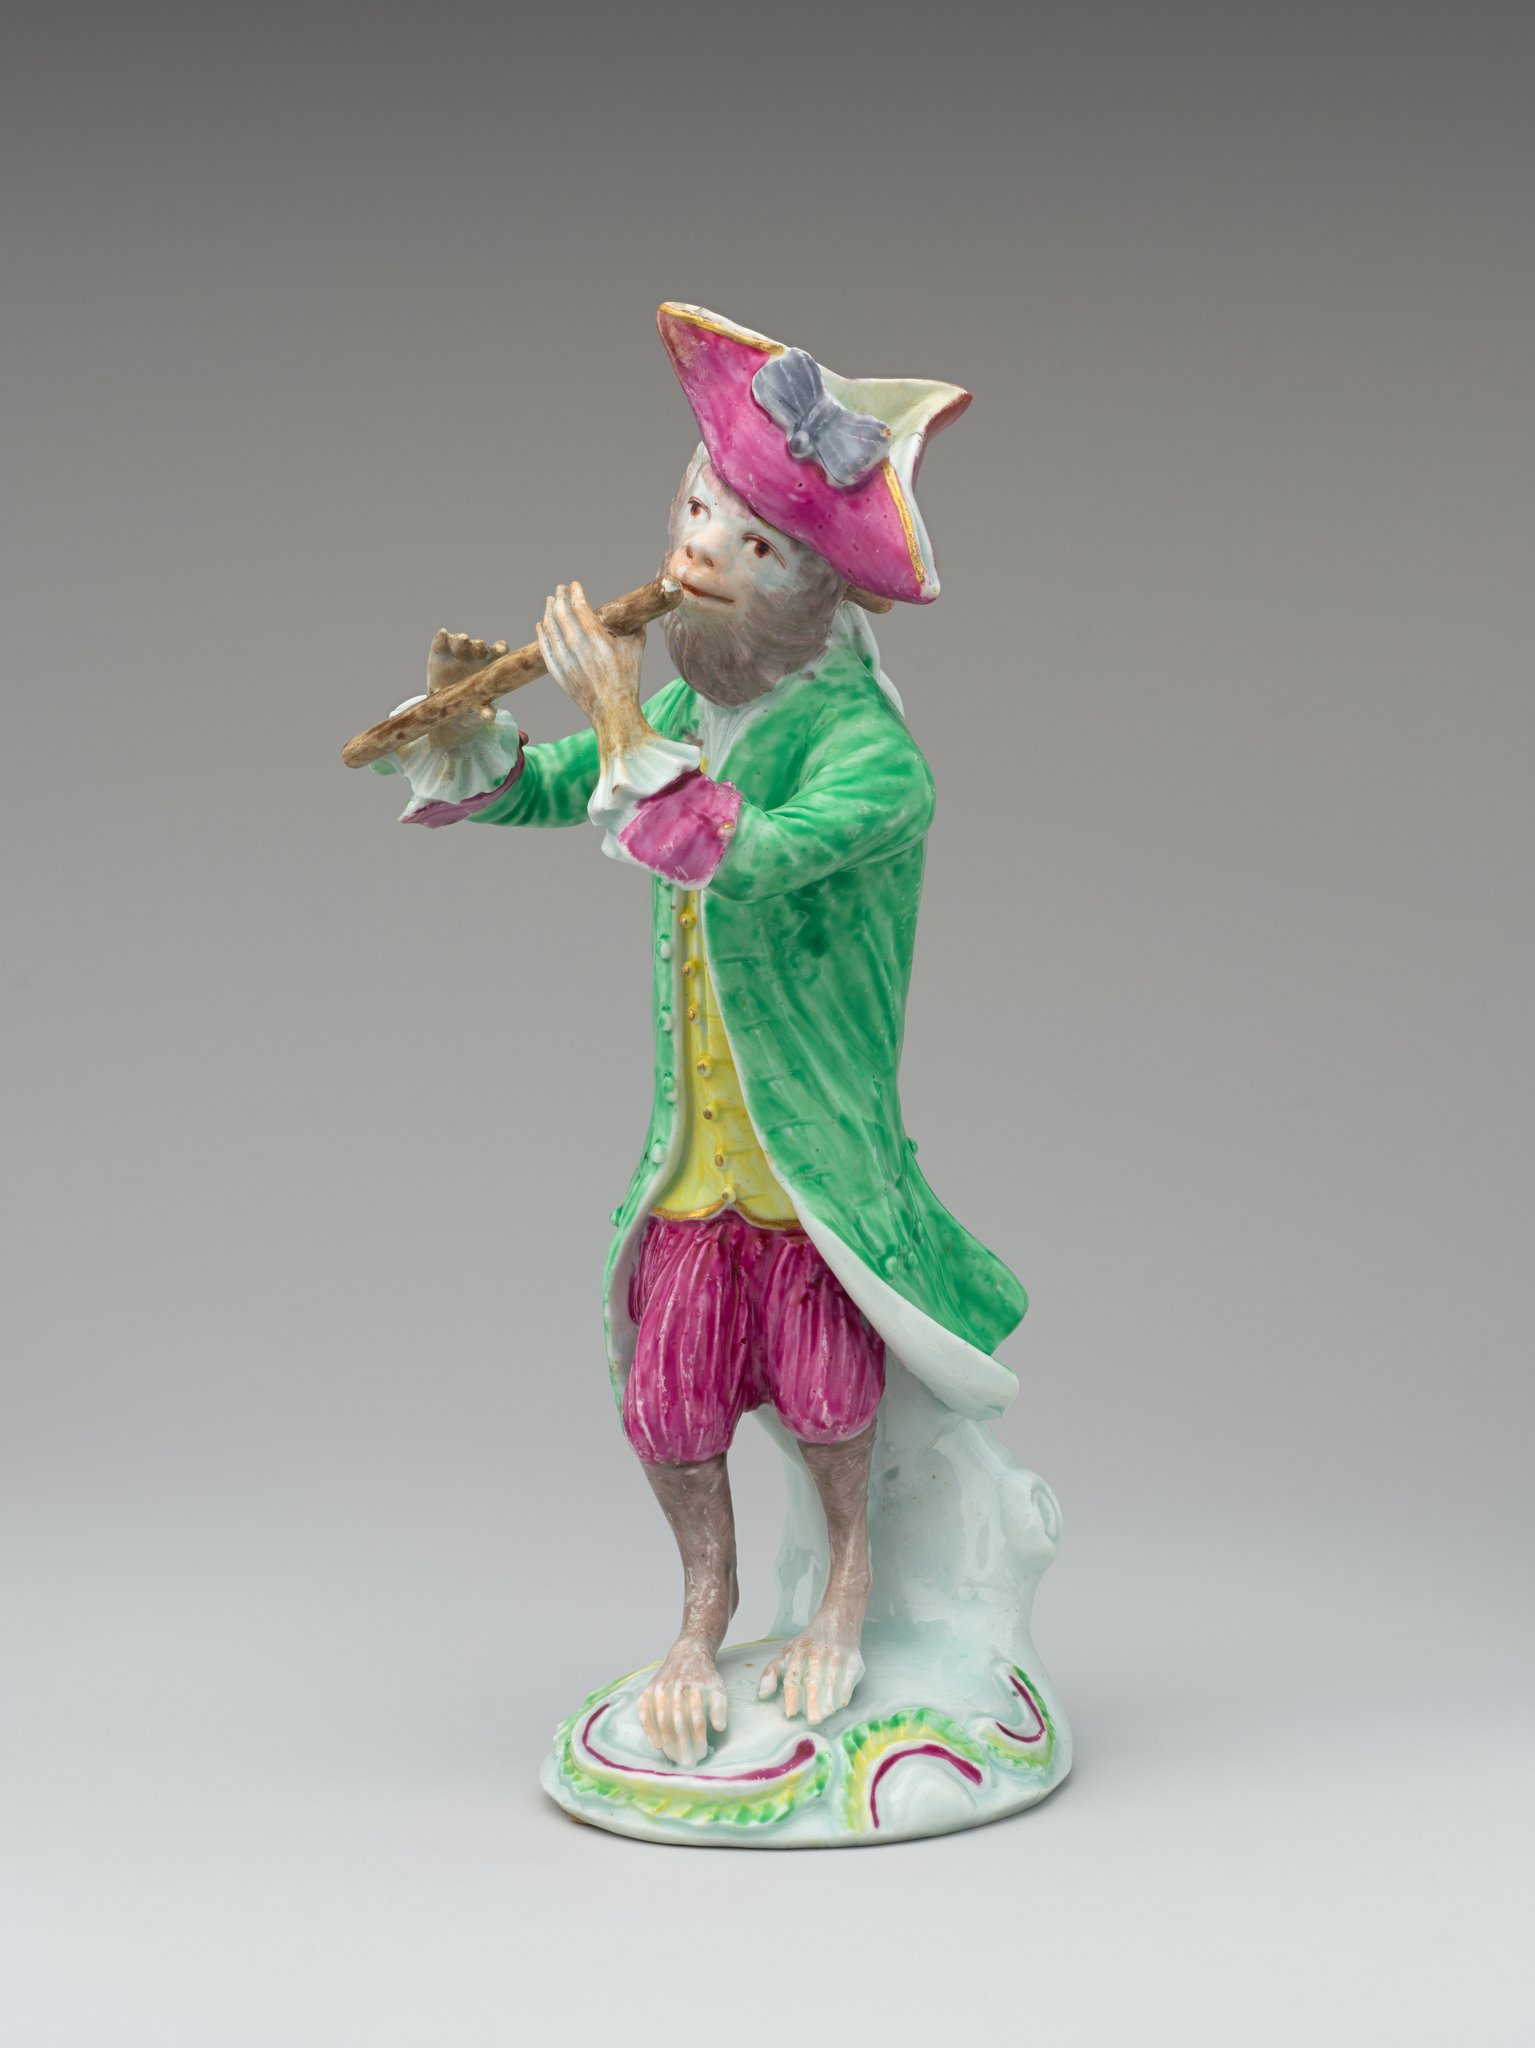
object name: figure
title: Monkey musician (part of a set)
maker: derby porcelain manufactory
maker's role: factory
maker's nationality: british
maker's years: 1751-1785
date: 1760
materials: soft paste porcelain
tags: musical instruments,music,flutes,monkeys